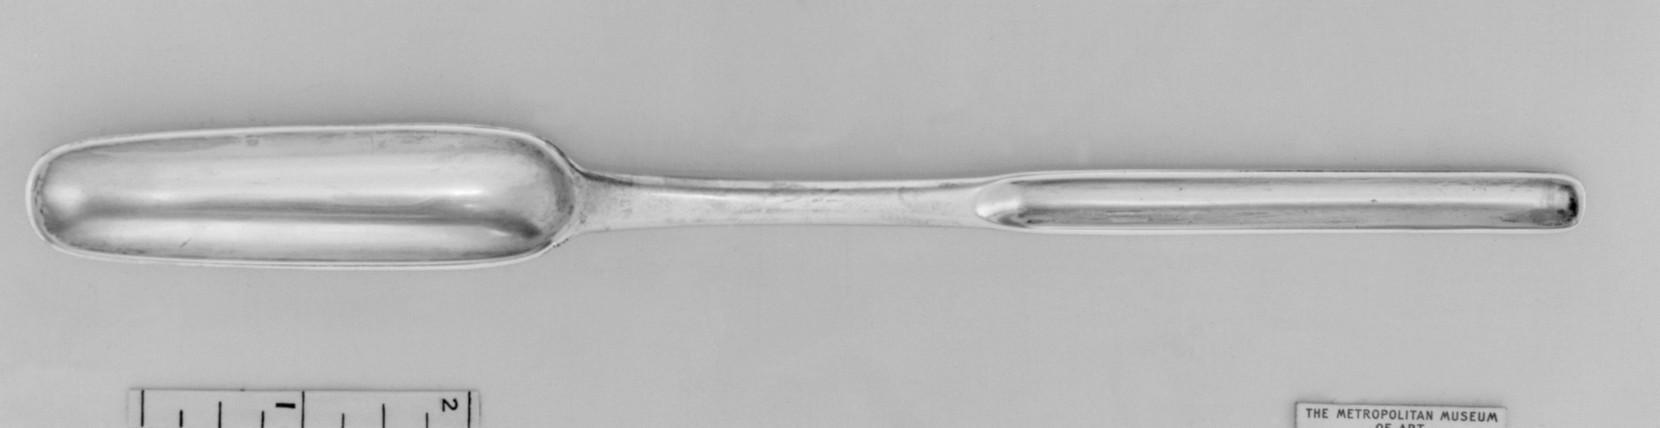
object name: marrow spoon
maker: thomas jackson i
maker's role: maker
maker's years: 1736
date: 1743-1744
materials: silver